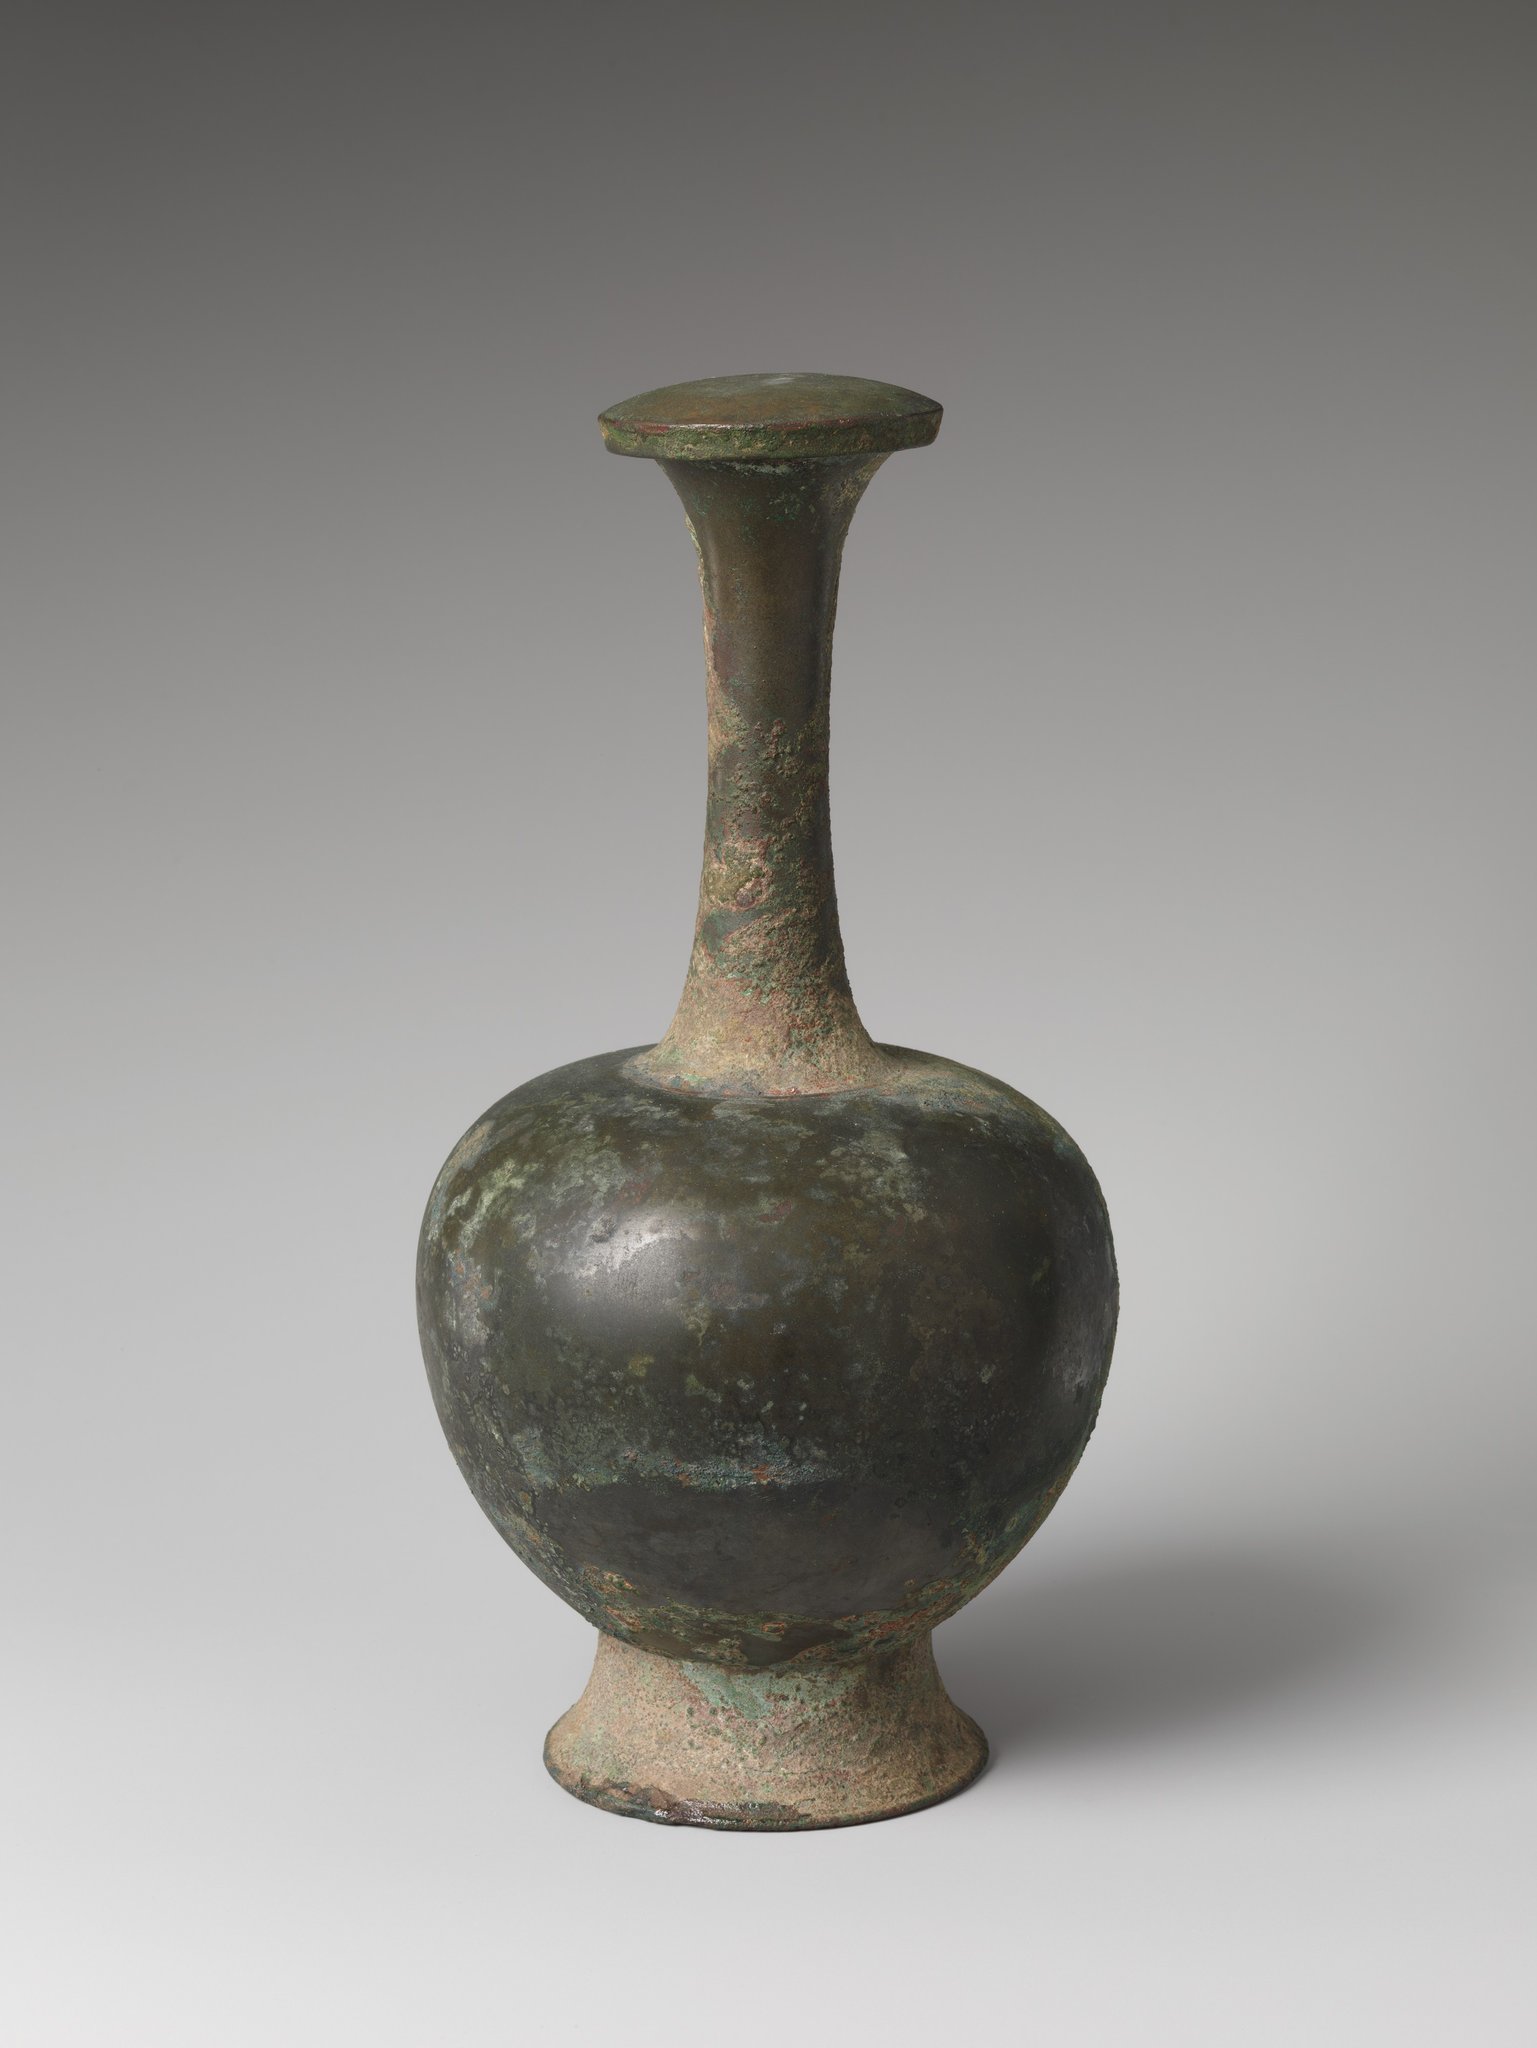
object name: wine container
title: Wine container (hu )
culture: chinese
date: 200-1 BCE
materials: bronze